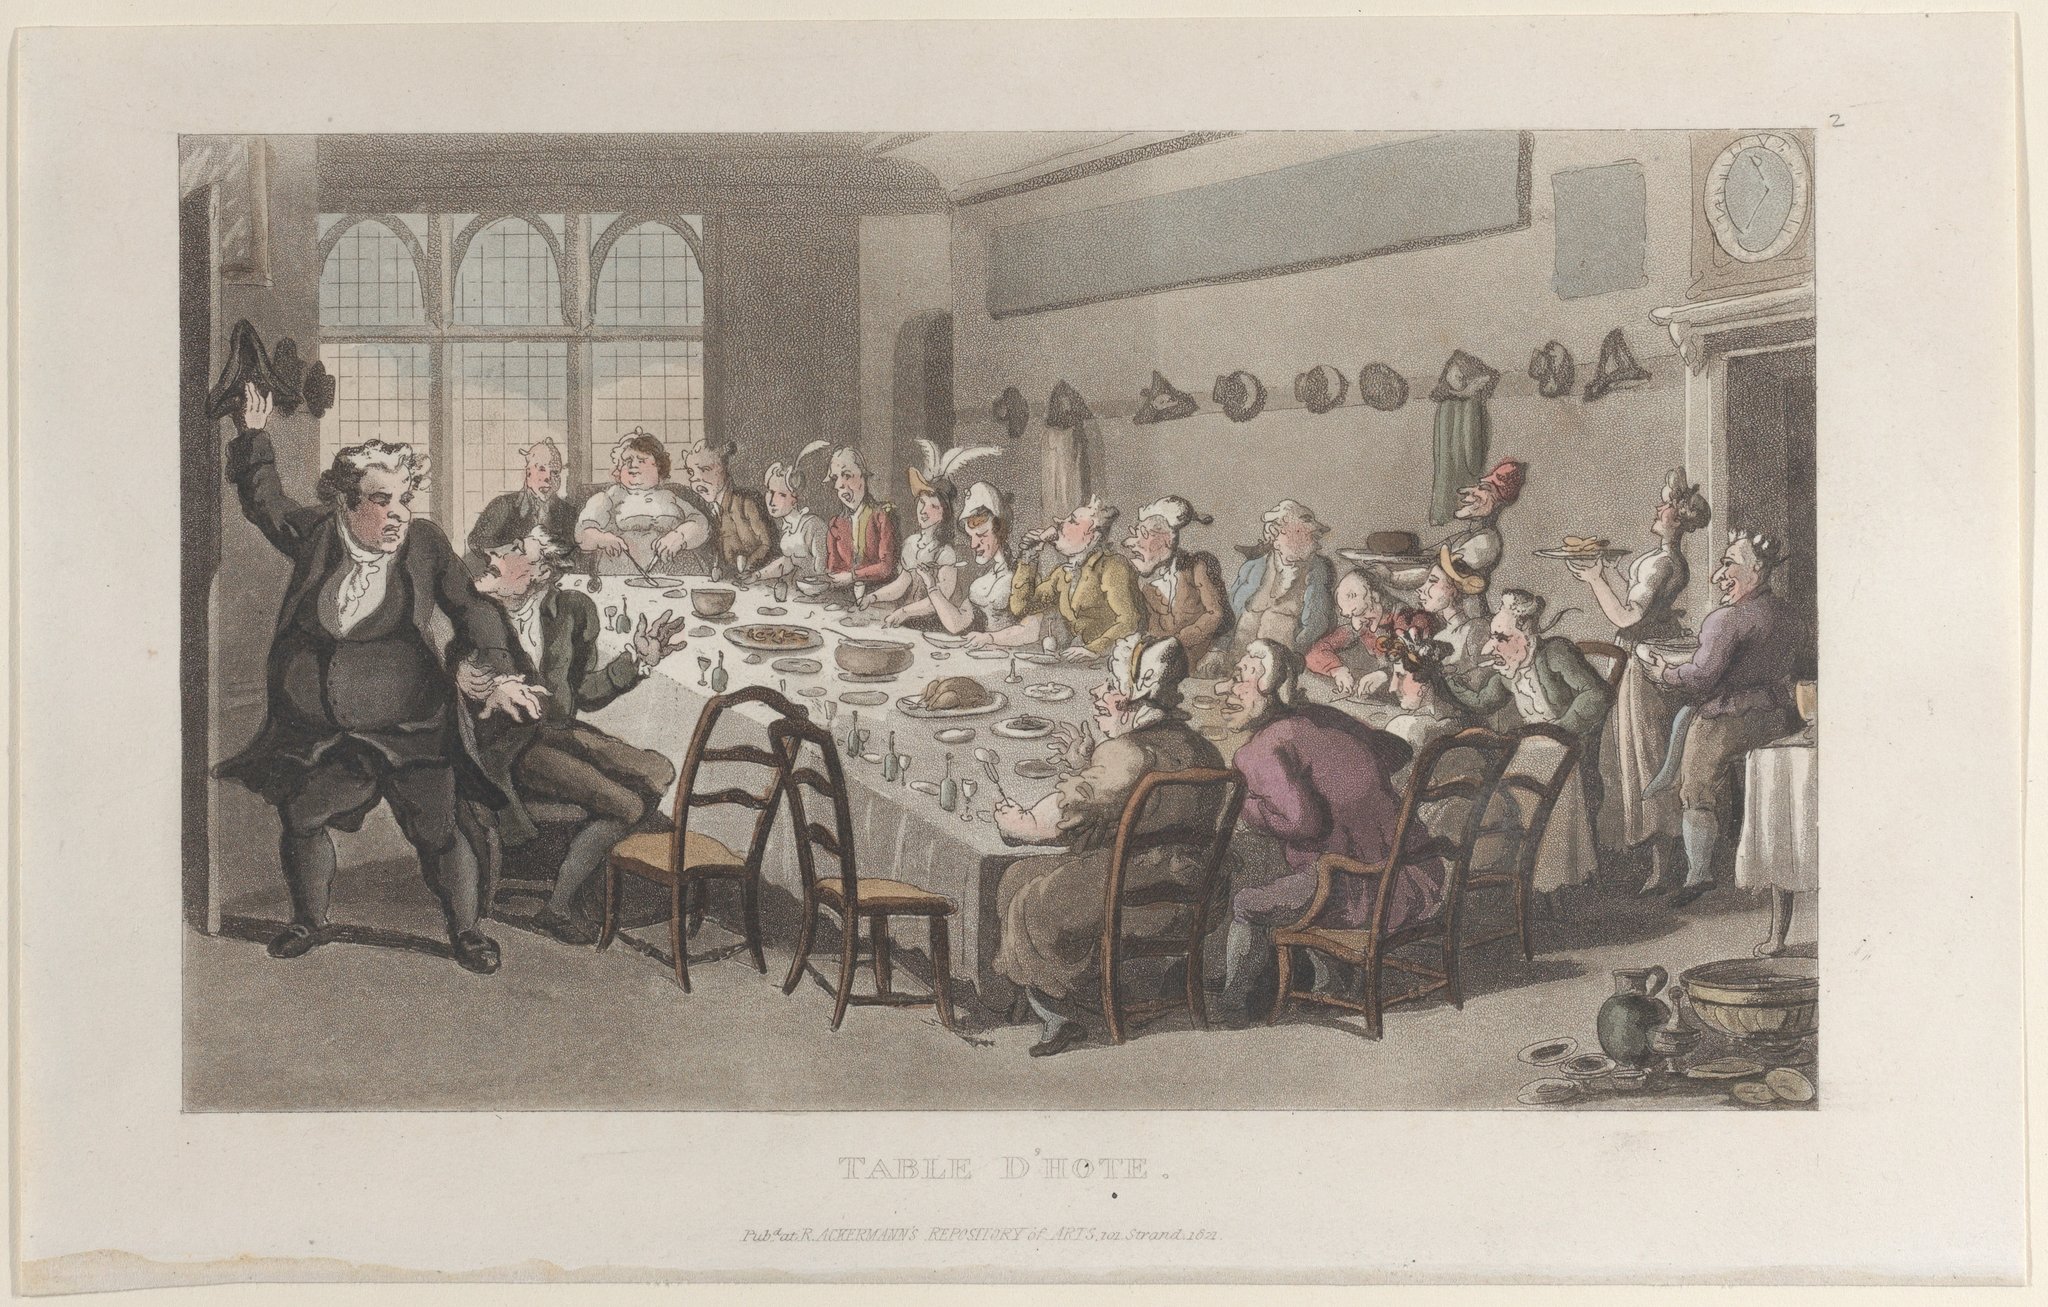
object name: print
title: Table d'Hote, from "Journal of Sentimental Travels in the Southern Provinces of France, Shortly Before the Revolution"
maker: thomas rowlandson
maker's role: artist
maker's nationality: british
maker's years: 1757-1827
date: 1821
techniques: aquatint, etching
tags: food,dining rooms,men,women,dining